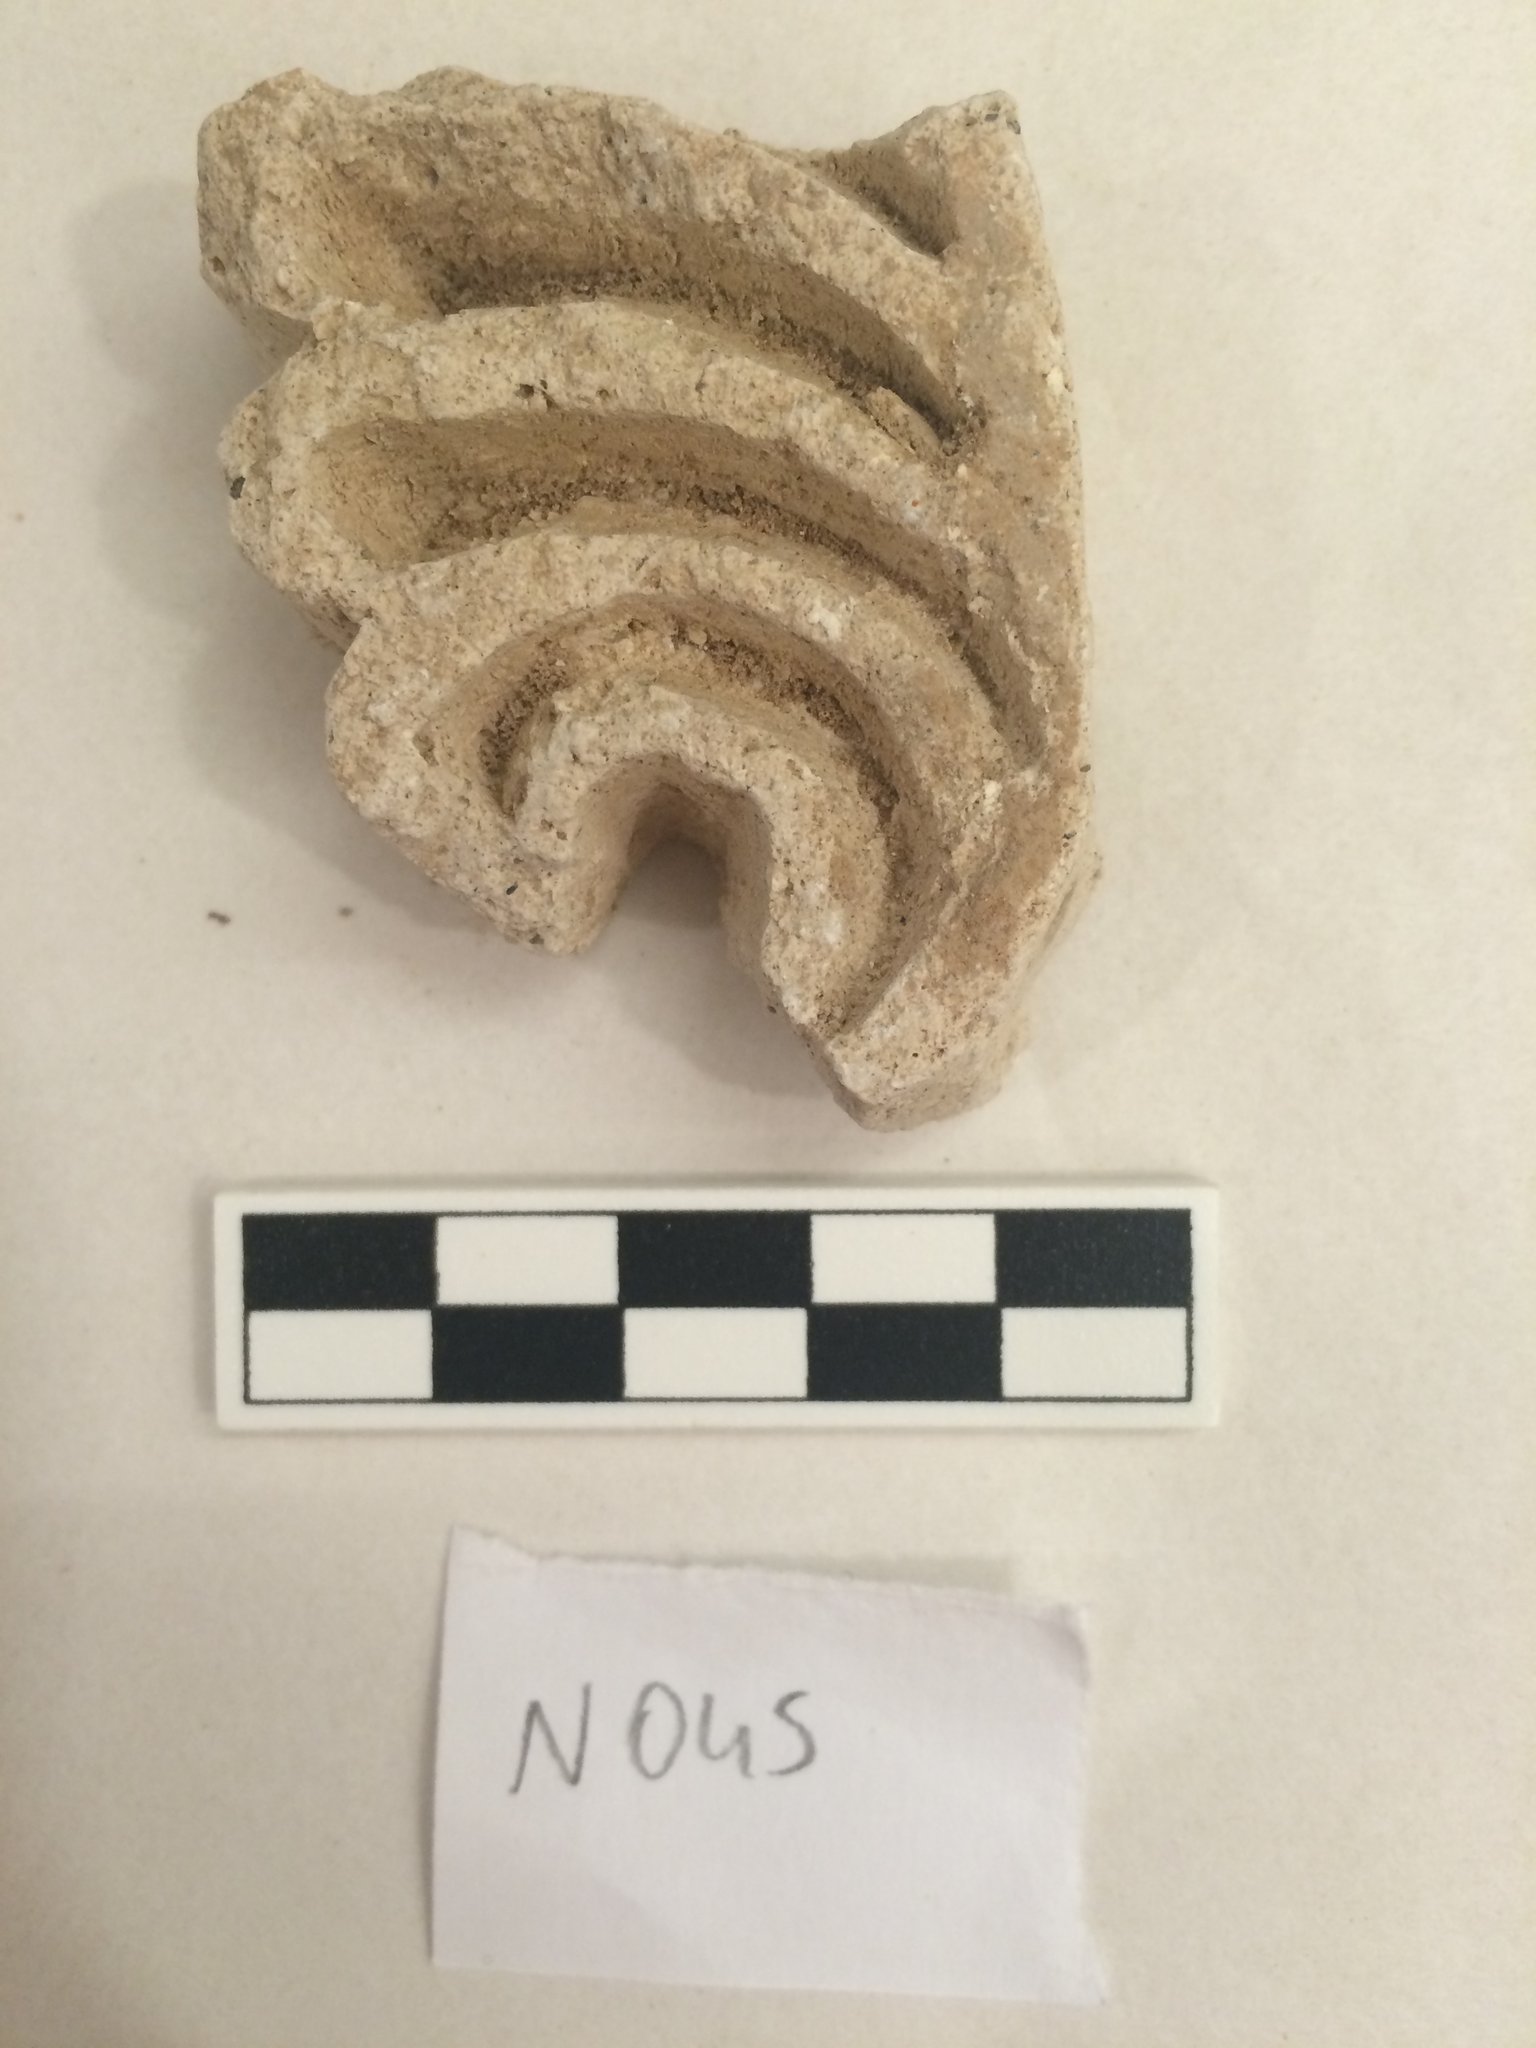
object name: fragment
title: Stucco Fragment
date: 701-1200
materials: plaster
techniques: carving, painting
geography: iran